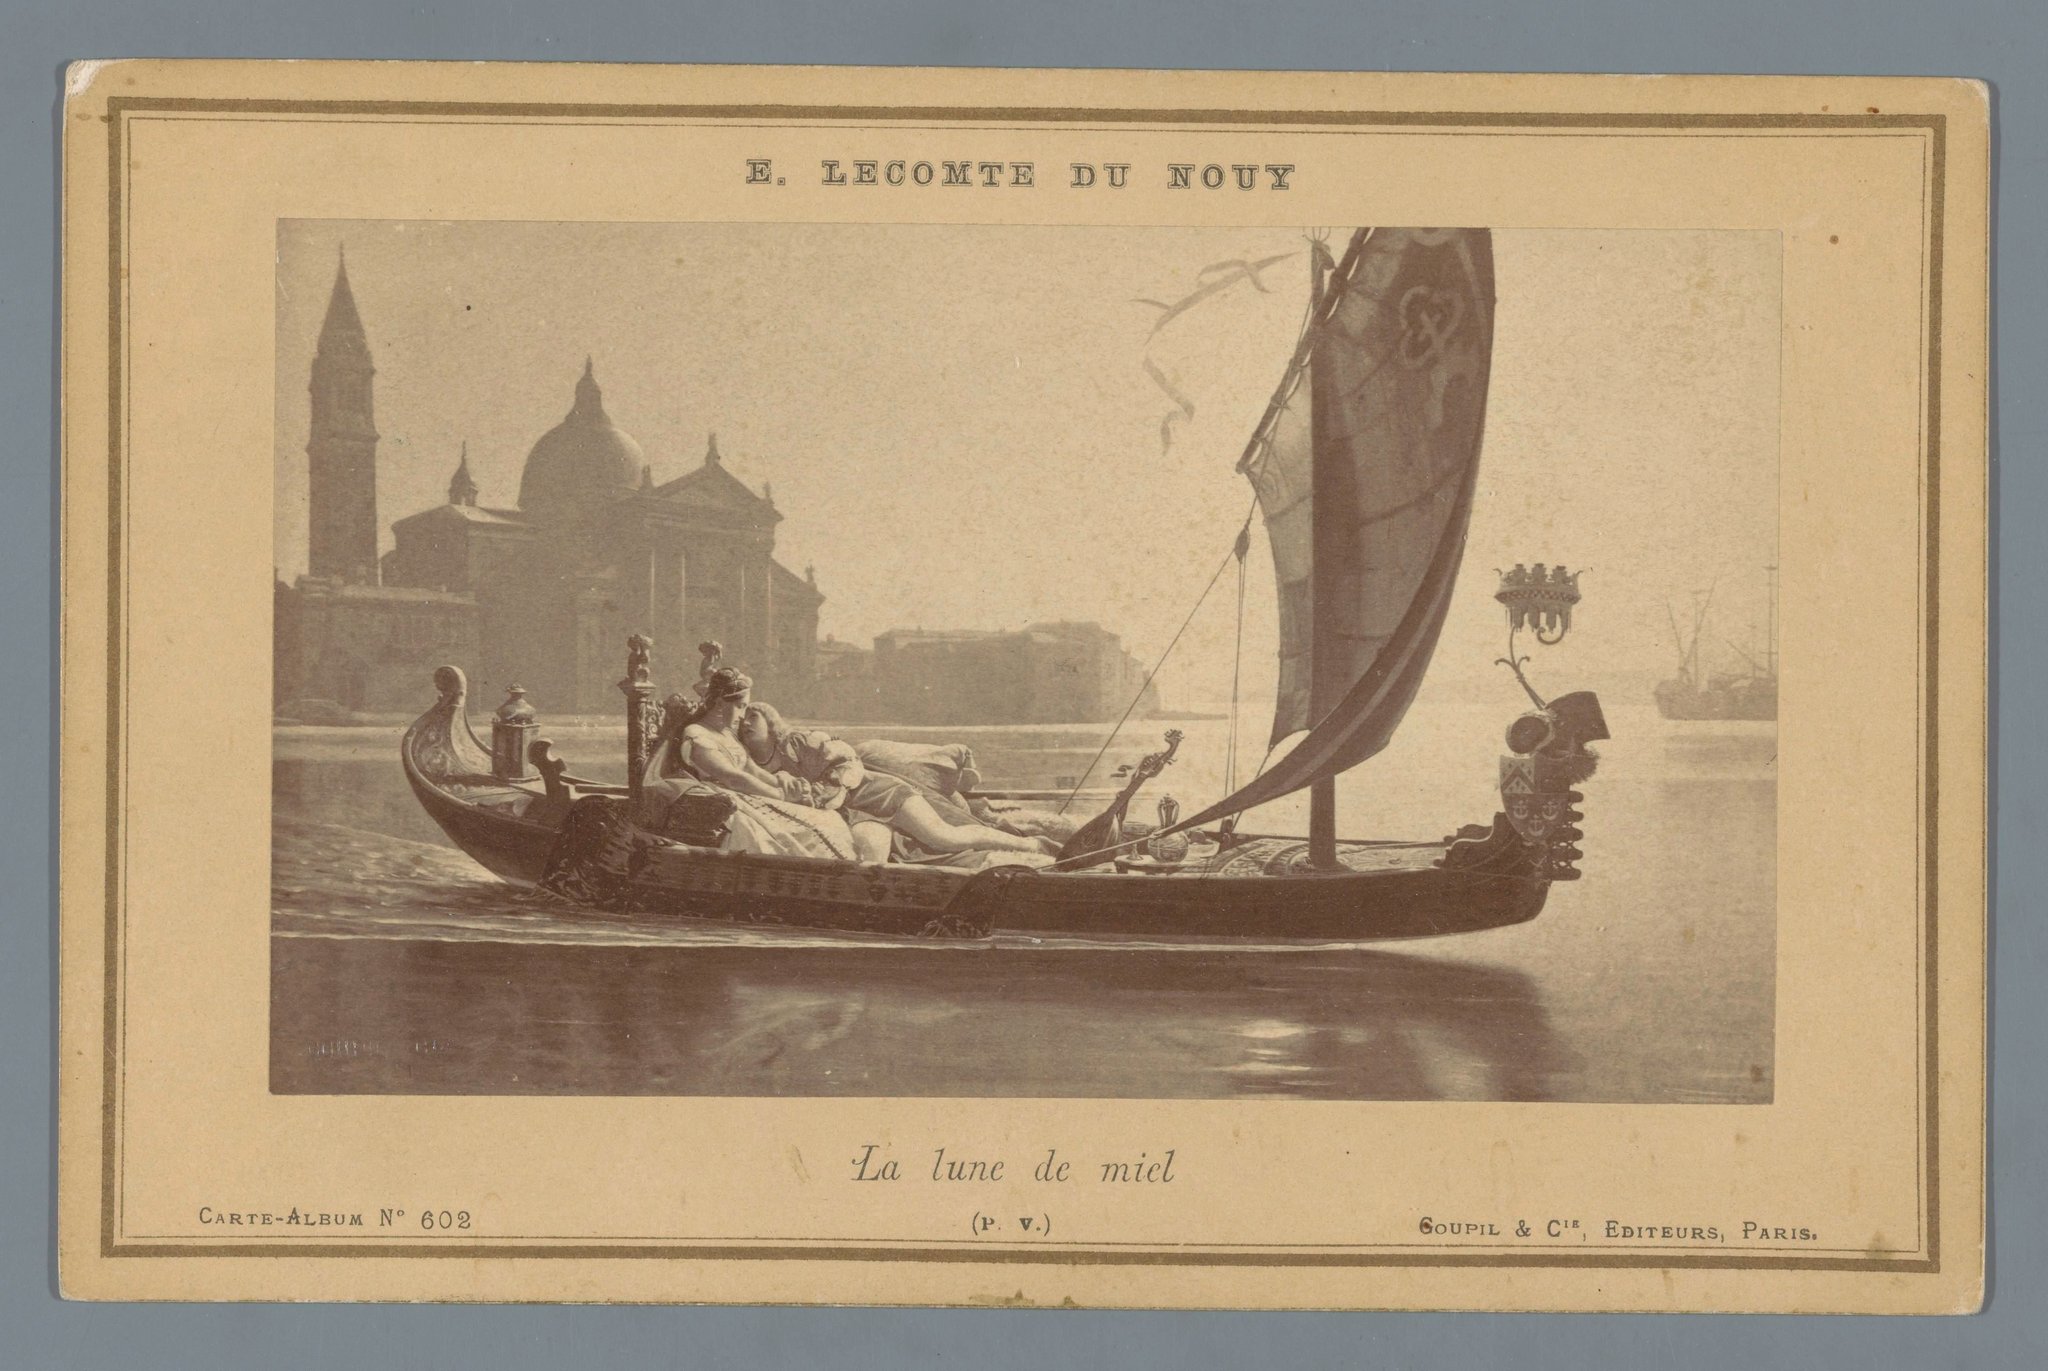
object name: cabinet photograph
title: Fotoreproductie van een schilderij van een boot met twee geliefden in Venetië door Jean-Jules-Antoine Lecomte du Nouÿ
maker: jean-jules-antoine lecomte du nouÿ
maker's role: painter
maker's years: 1842-1923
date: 1880-1910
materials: cardboard, photographic support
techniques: albumen print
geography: paris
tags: wedding trip, honeymoon, rowing-boat, canoe, etc., venice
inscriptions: number: ‘Carte-Album No. 602’